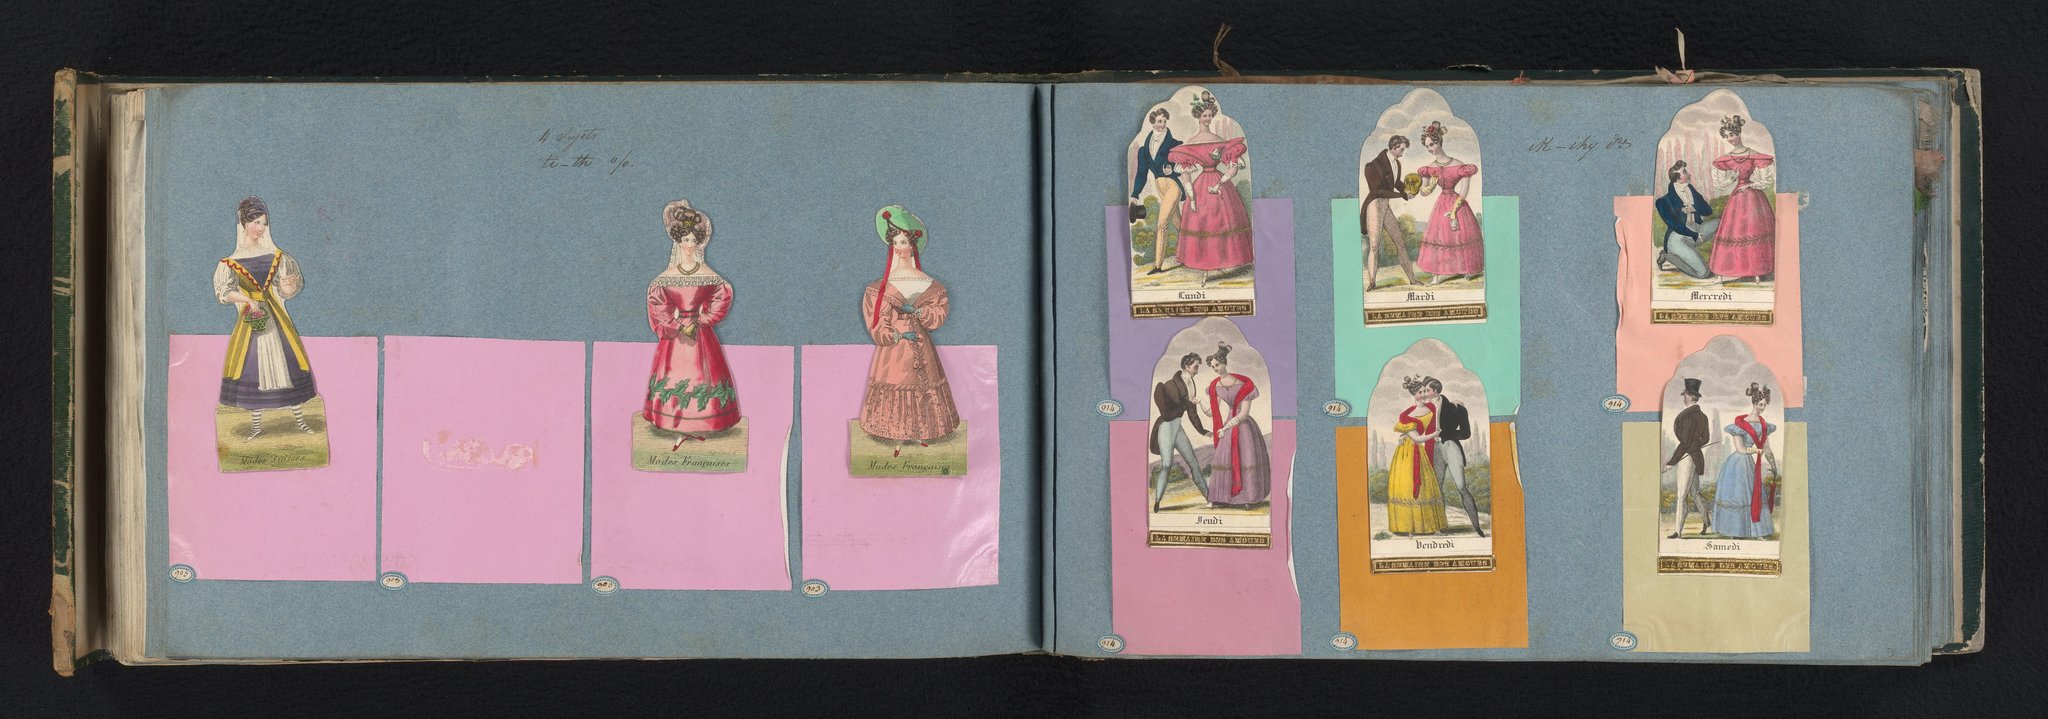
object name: print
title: Twee bladzijden met stalen van opgeplakte figuren op gekleurd papier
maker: Anonymous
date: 1830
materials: gold leaf, ink, paper, watercolor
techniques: manufacturing, etching, hand coloring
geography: france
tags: ornaments ~ art, dolls for adults, folk costume, regional costume, lovers; courting, flirting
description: Twee bladzijden met 9 complete stalen van verschillende figuren, op gekleurd papier. Links drie poppen met op voor- en achterzijde gedrukte en ingekleurde figuren (één ontbreekt) van staande vrouwen in verschillende nationale kostuums, opgeplakt op roze gekleurd papier. Rechts zes voorstellingen met op de voorzijde galante scènes van eigentijdse mannen en vrouwen met de dagen van de week, gedrukt en ingekleurd met opschriften van goudkleurig metaalpapier 'La Semaine des Amours'. Op de achterzijde vergelijkbare amoureuze scènes, maar dan in een mythologische setting, met Cupido. Alle stalen voorzien van etiketten met nummers (903-914) en handgeschreven codes. Onderdeel van het stalenboek geschonken door de dames Van Rijn, vermoedelijk van een Franse papierfabrikant van luxe papieren, of diens vertegenwoordiger in Nederland, ca. 1830.